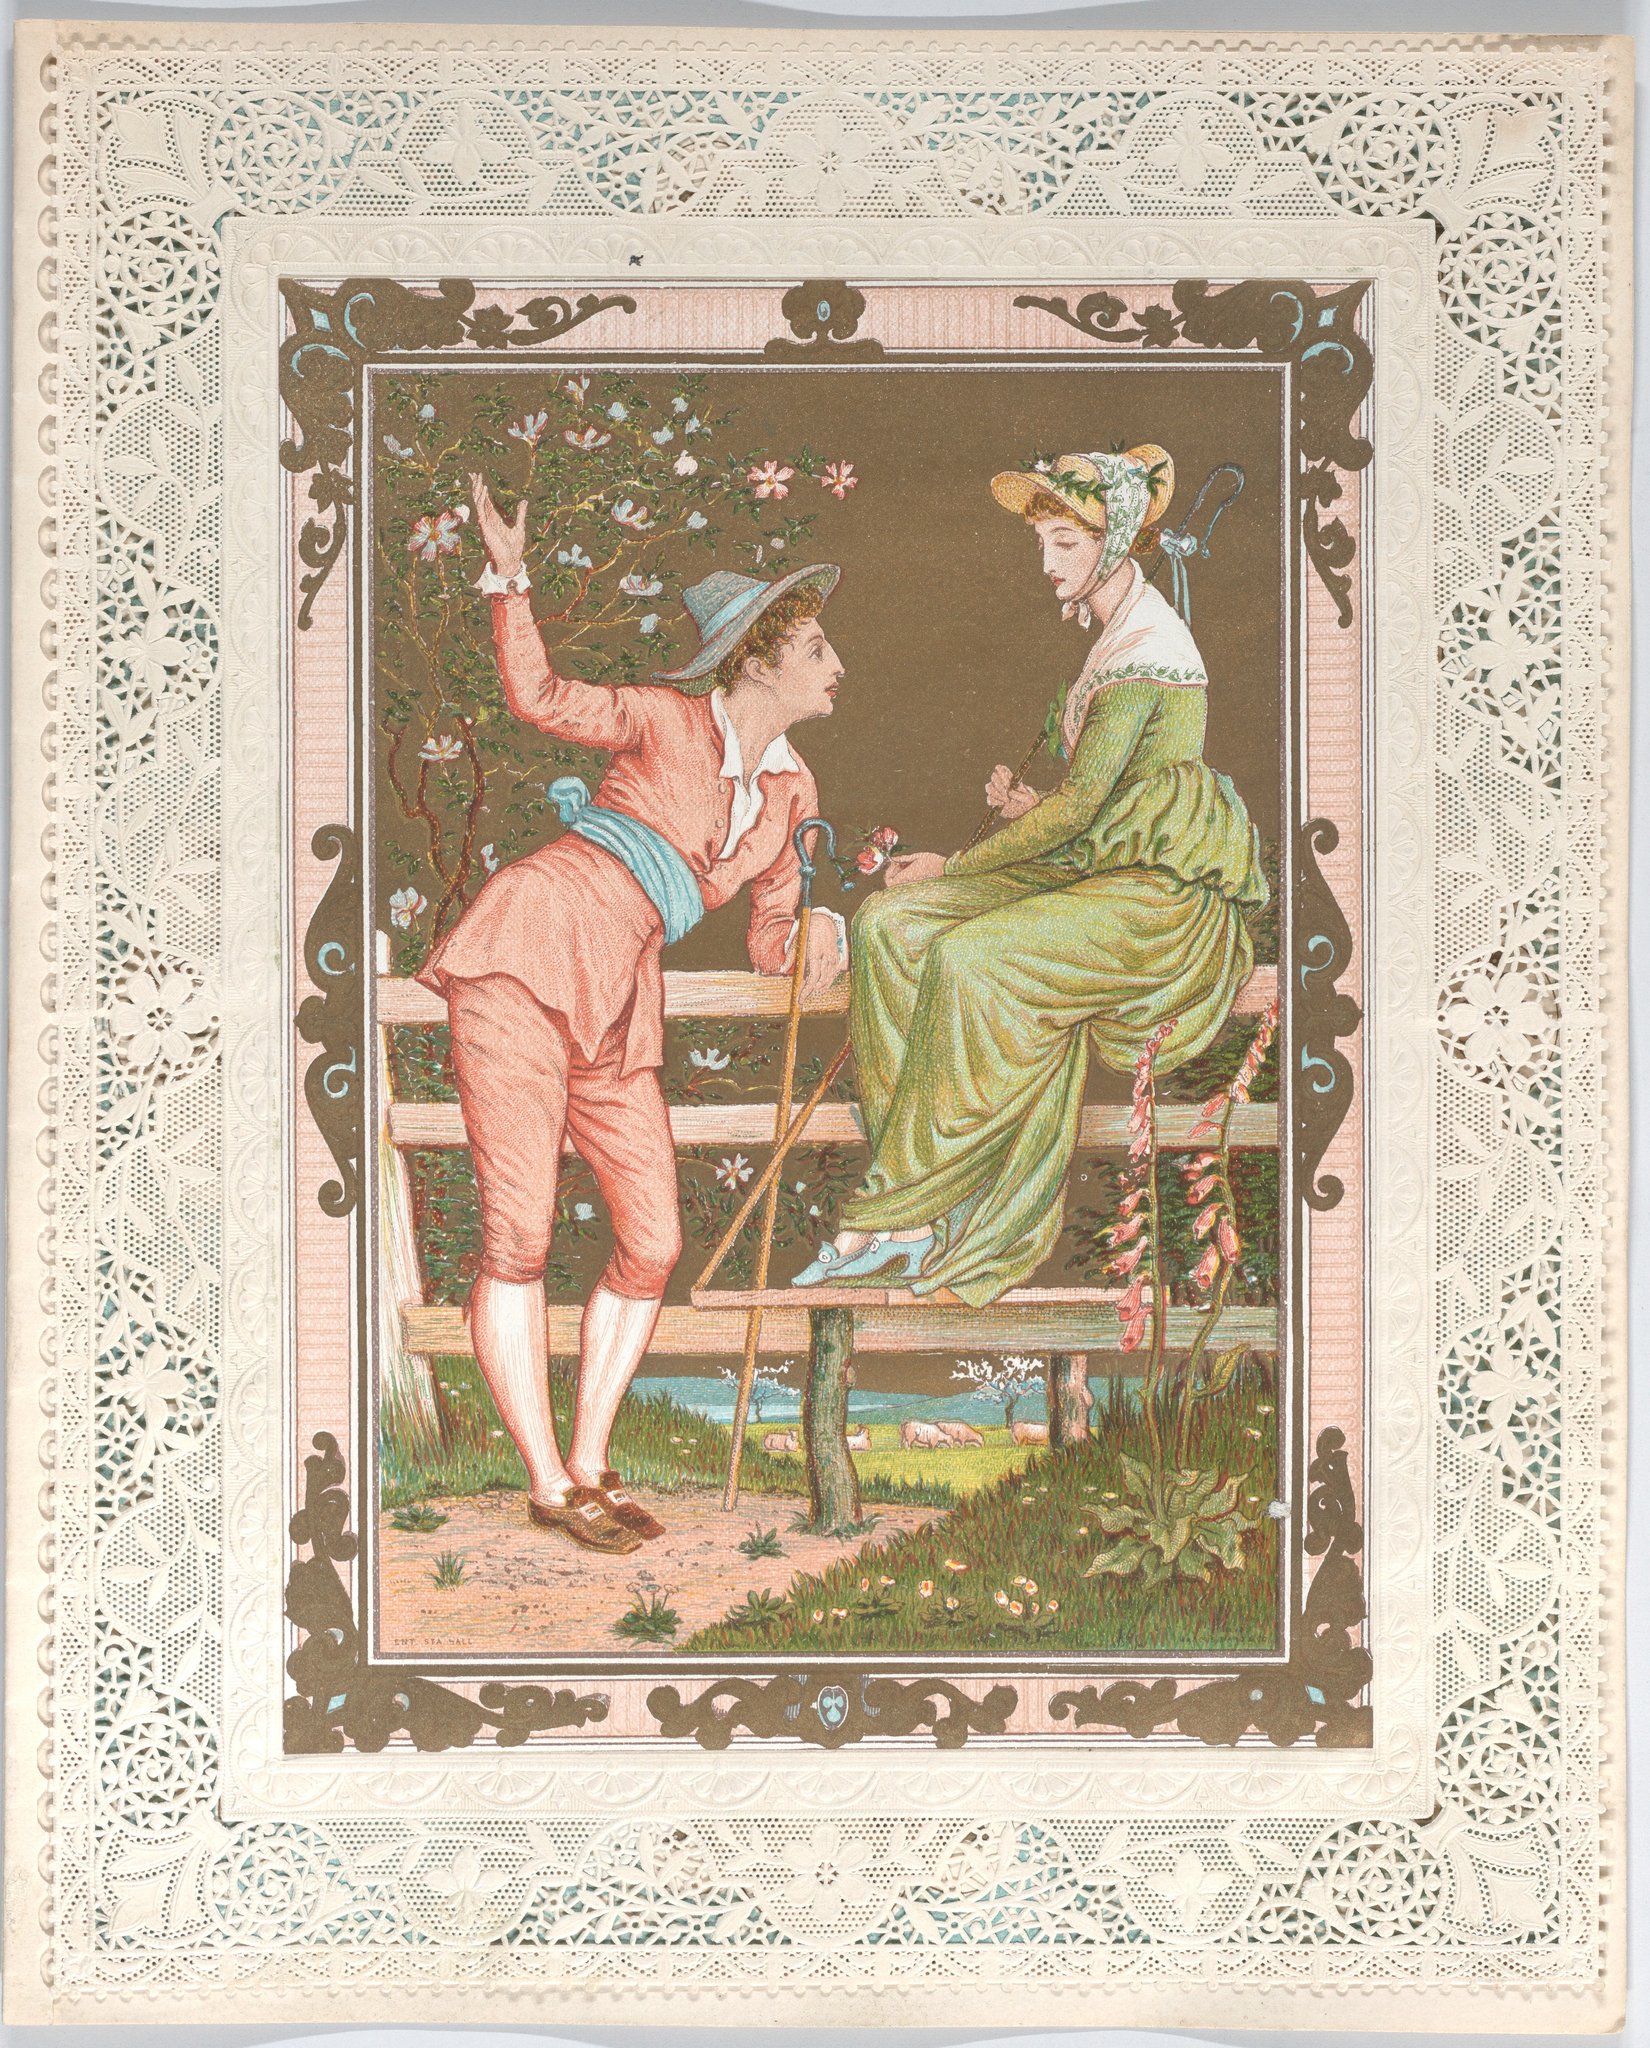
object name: valentine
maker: walter crane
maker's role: artist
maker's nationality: british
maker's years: 1845-1915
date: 1876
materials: gold, lace, paper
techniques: chromolithography, gilding, lithograph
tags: couples,men,women